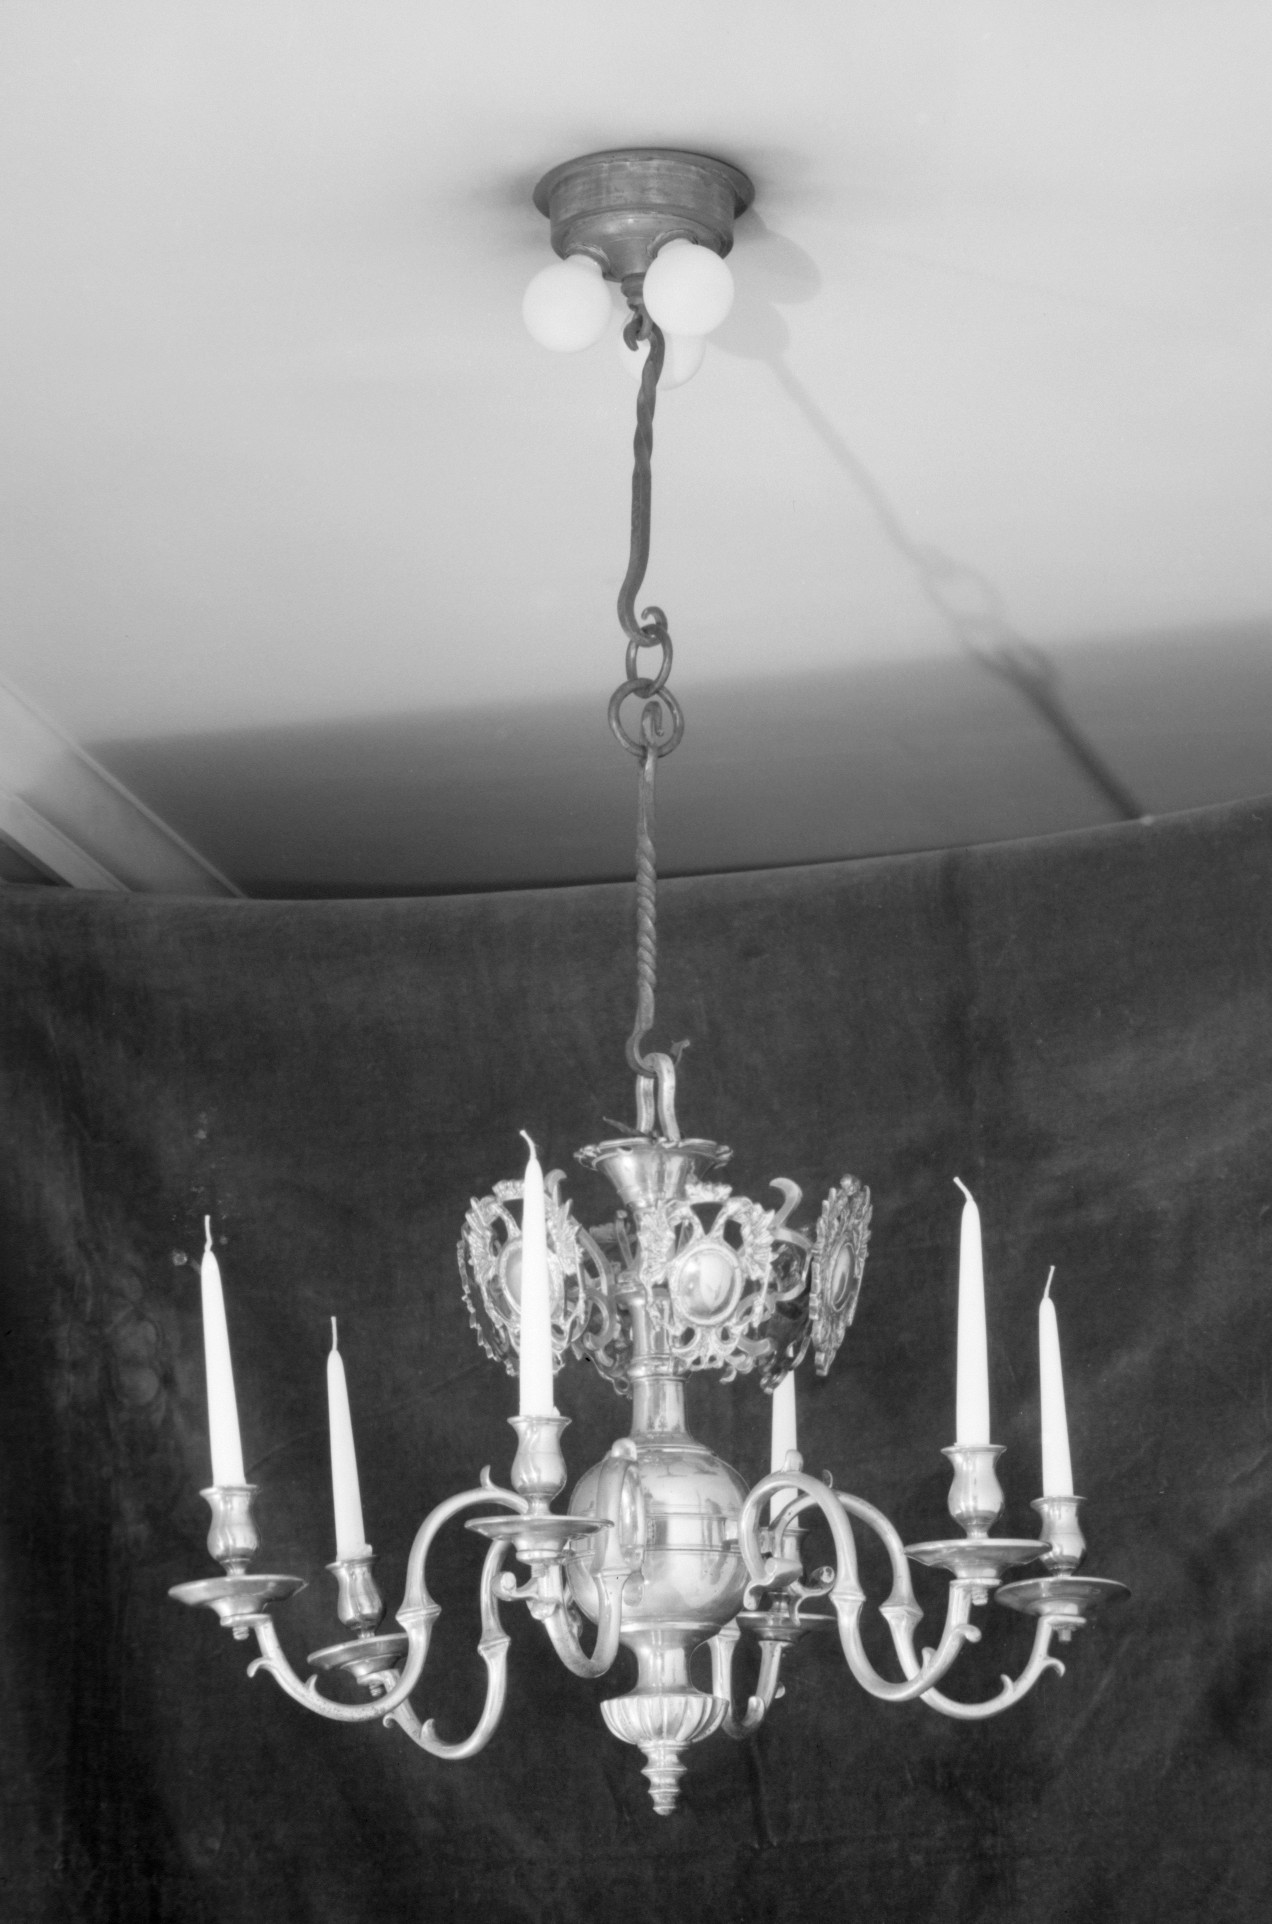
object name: chandelier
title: Six-light chandelier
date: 1651-1700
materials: brass